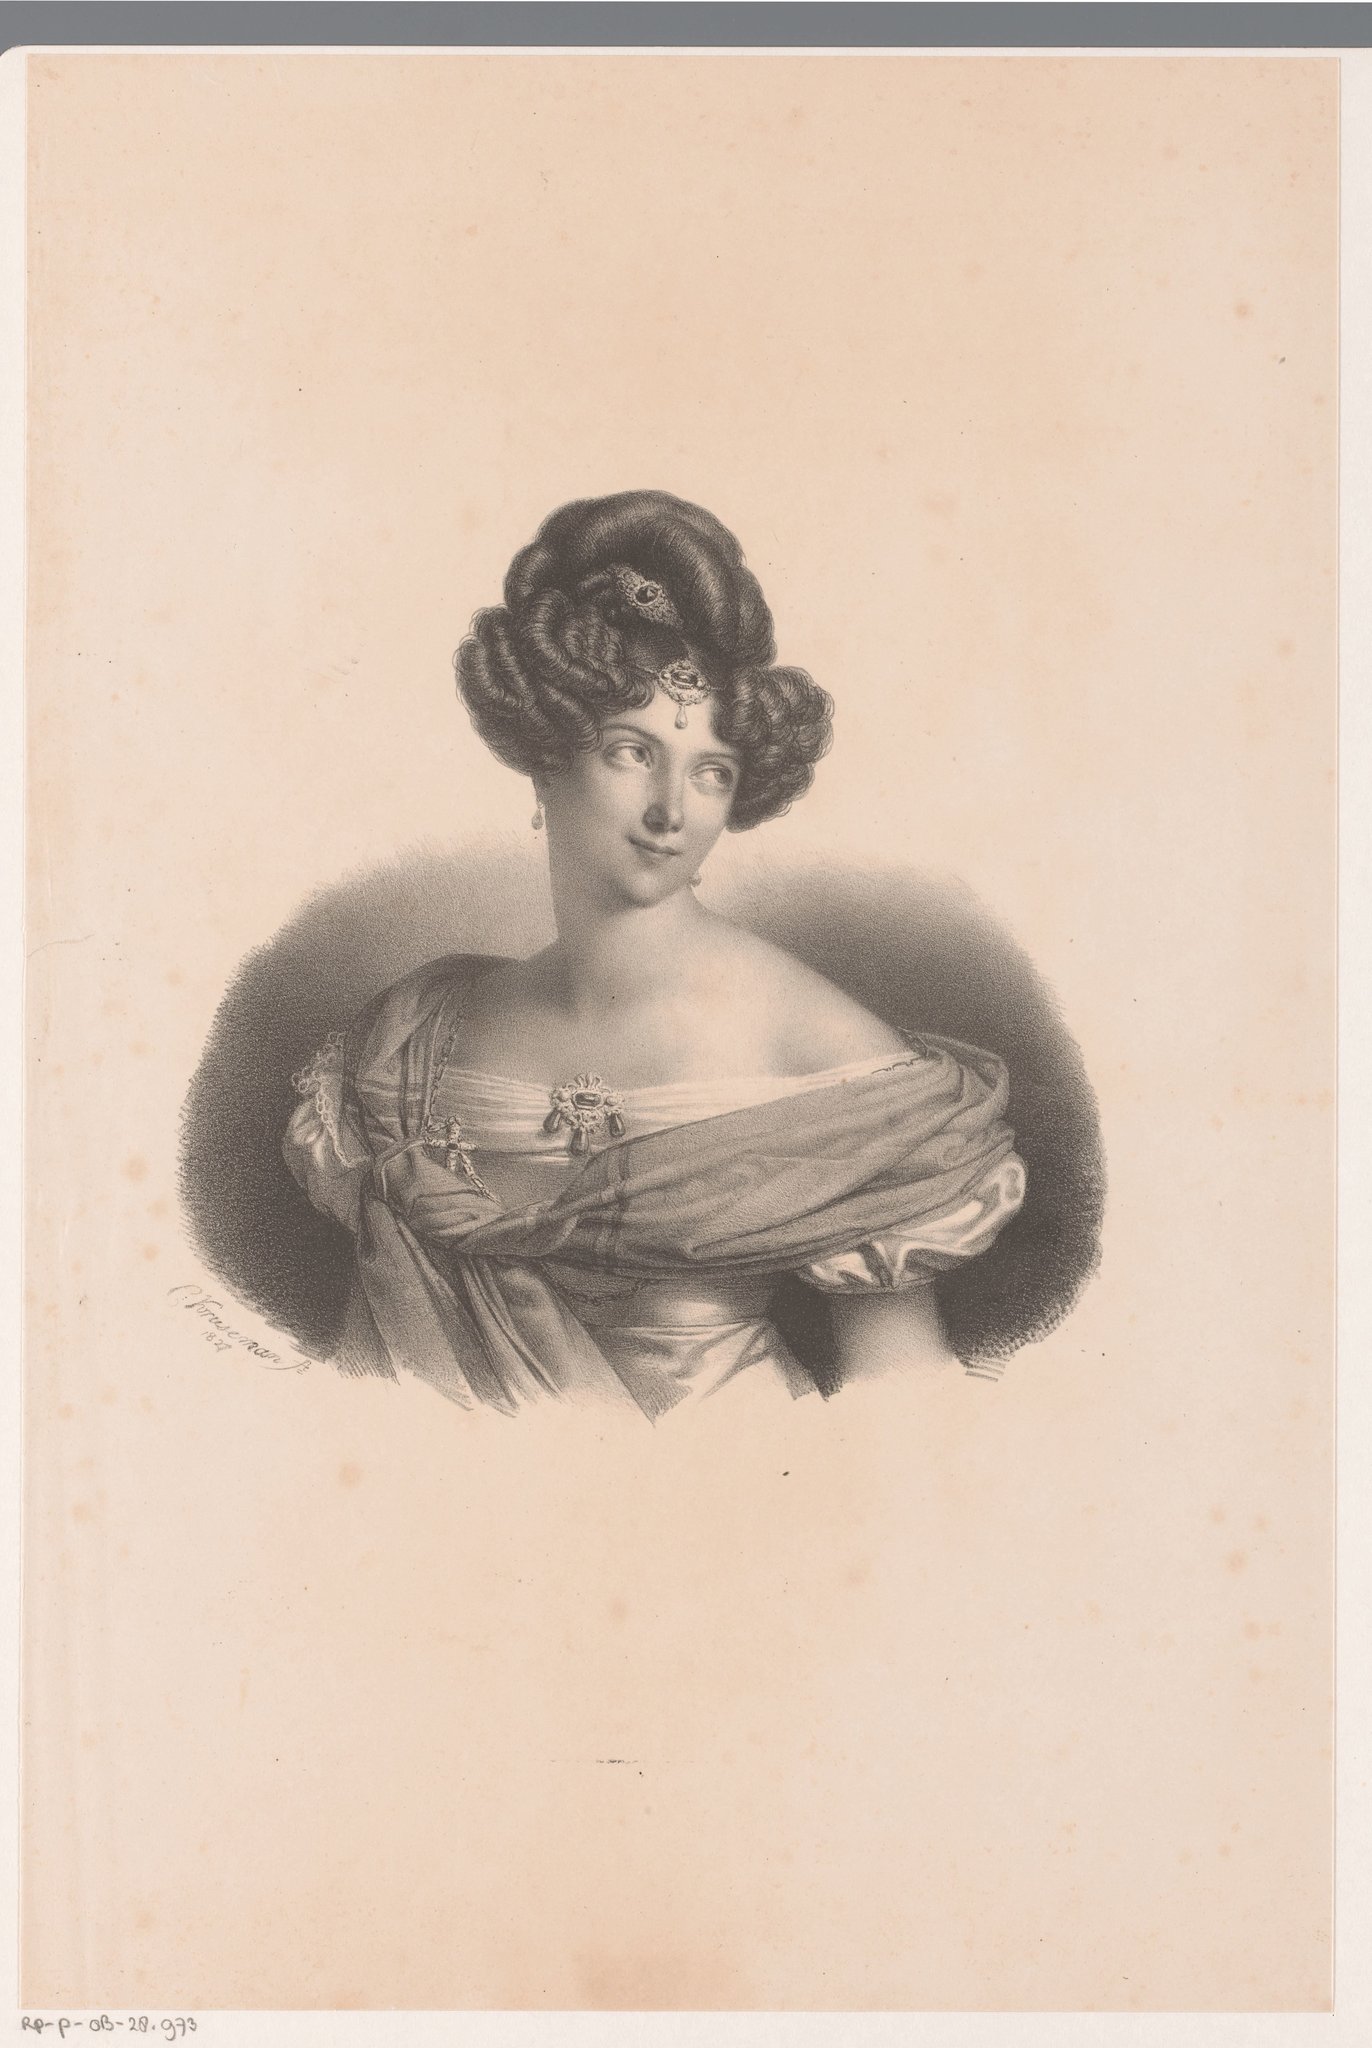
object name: print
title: Portret van Henriette Sontag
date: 1827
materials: paper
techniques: lithograph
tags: historical persons - bb - woman (+ (full) bust portrait)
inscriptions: collector's mark: Lugt 2228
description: De prenten RP-P-OB-28.972 en RP-P-1892-A-16960 zijn gemaakt door dezelfde prentmaker, vermoedelijk Cornelis Kruseman. De prenten RP-P-OB28.973 en RP-1882-A-6399 zijn door een andere prentmaker gemaakt. Alle prenten zijn in ieder geval naar een ontwerp van Cornelis Kruseman.